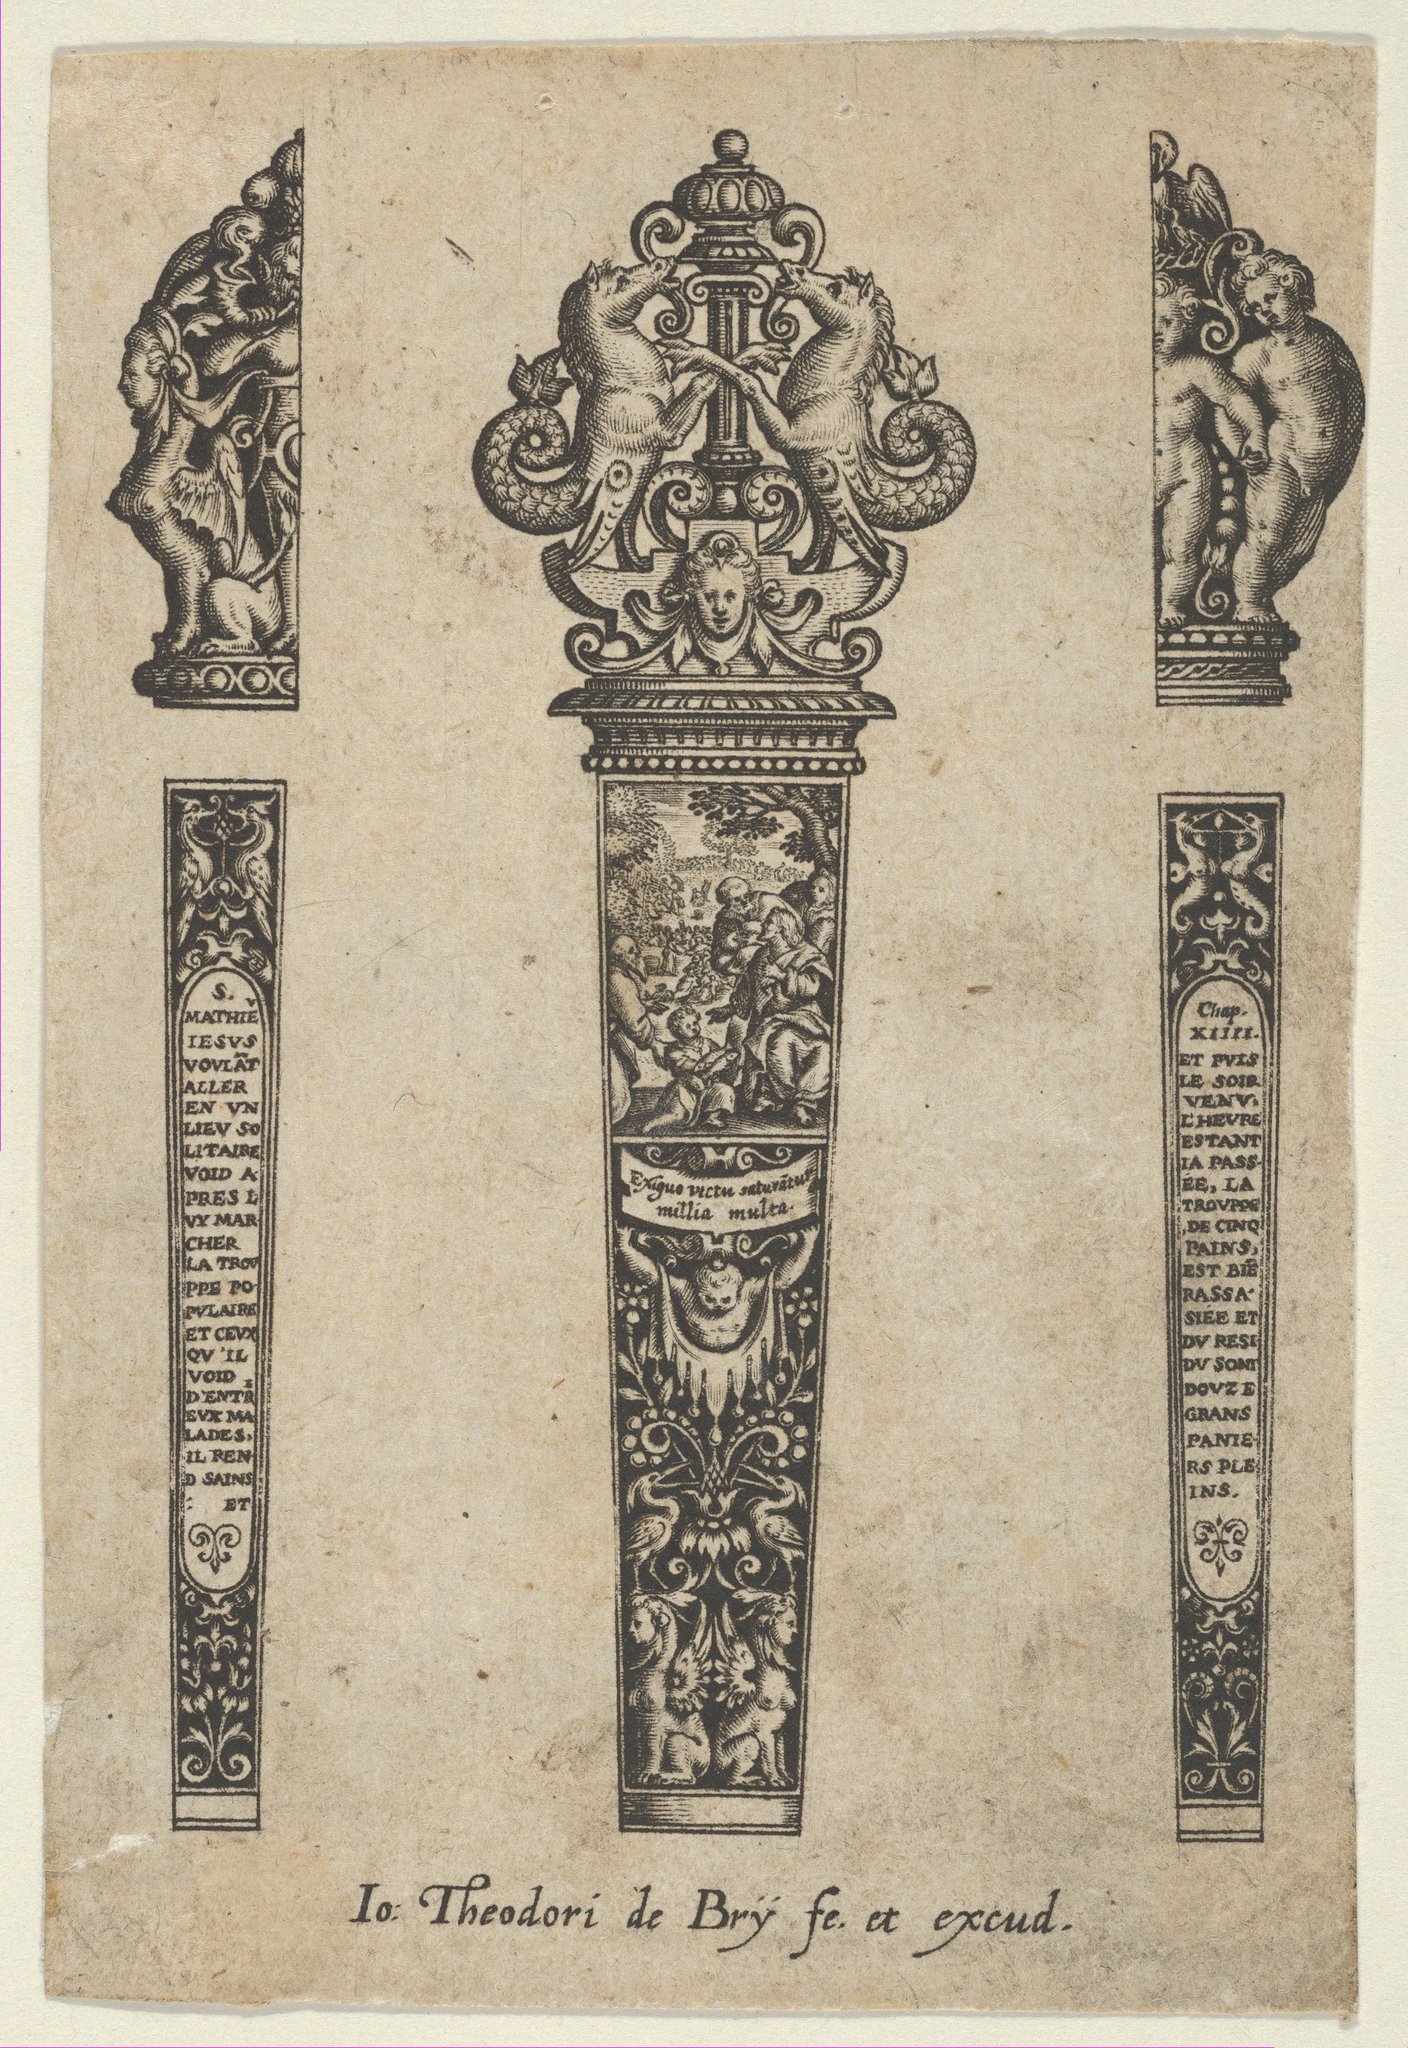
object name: print ornament architecture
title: Design for a Knife Handle with the Sermon on the Mount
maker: johann theodor de bry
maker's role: artist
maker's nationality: netherlandish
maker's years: 1561-1623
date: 1580-1600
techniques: embroidery, engraving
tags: hilts,grotesques,ornament,mythical creatures